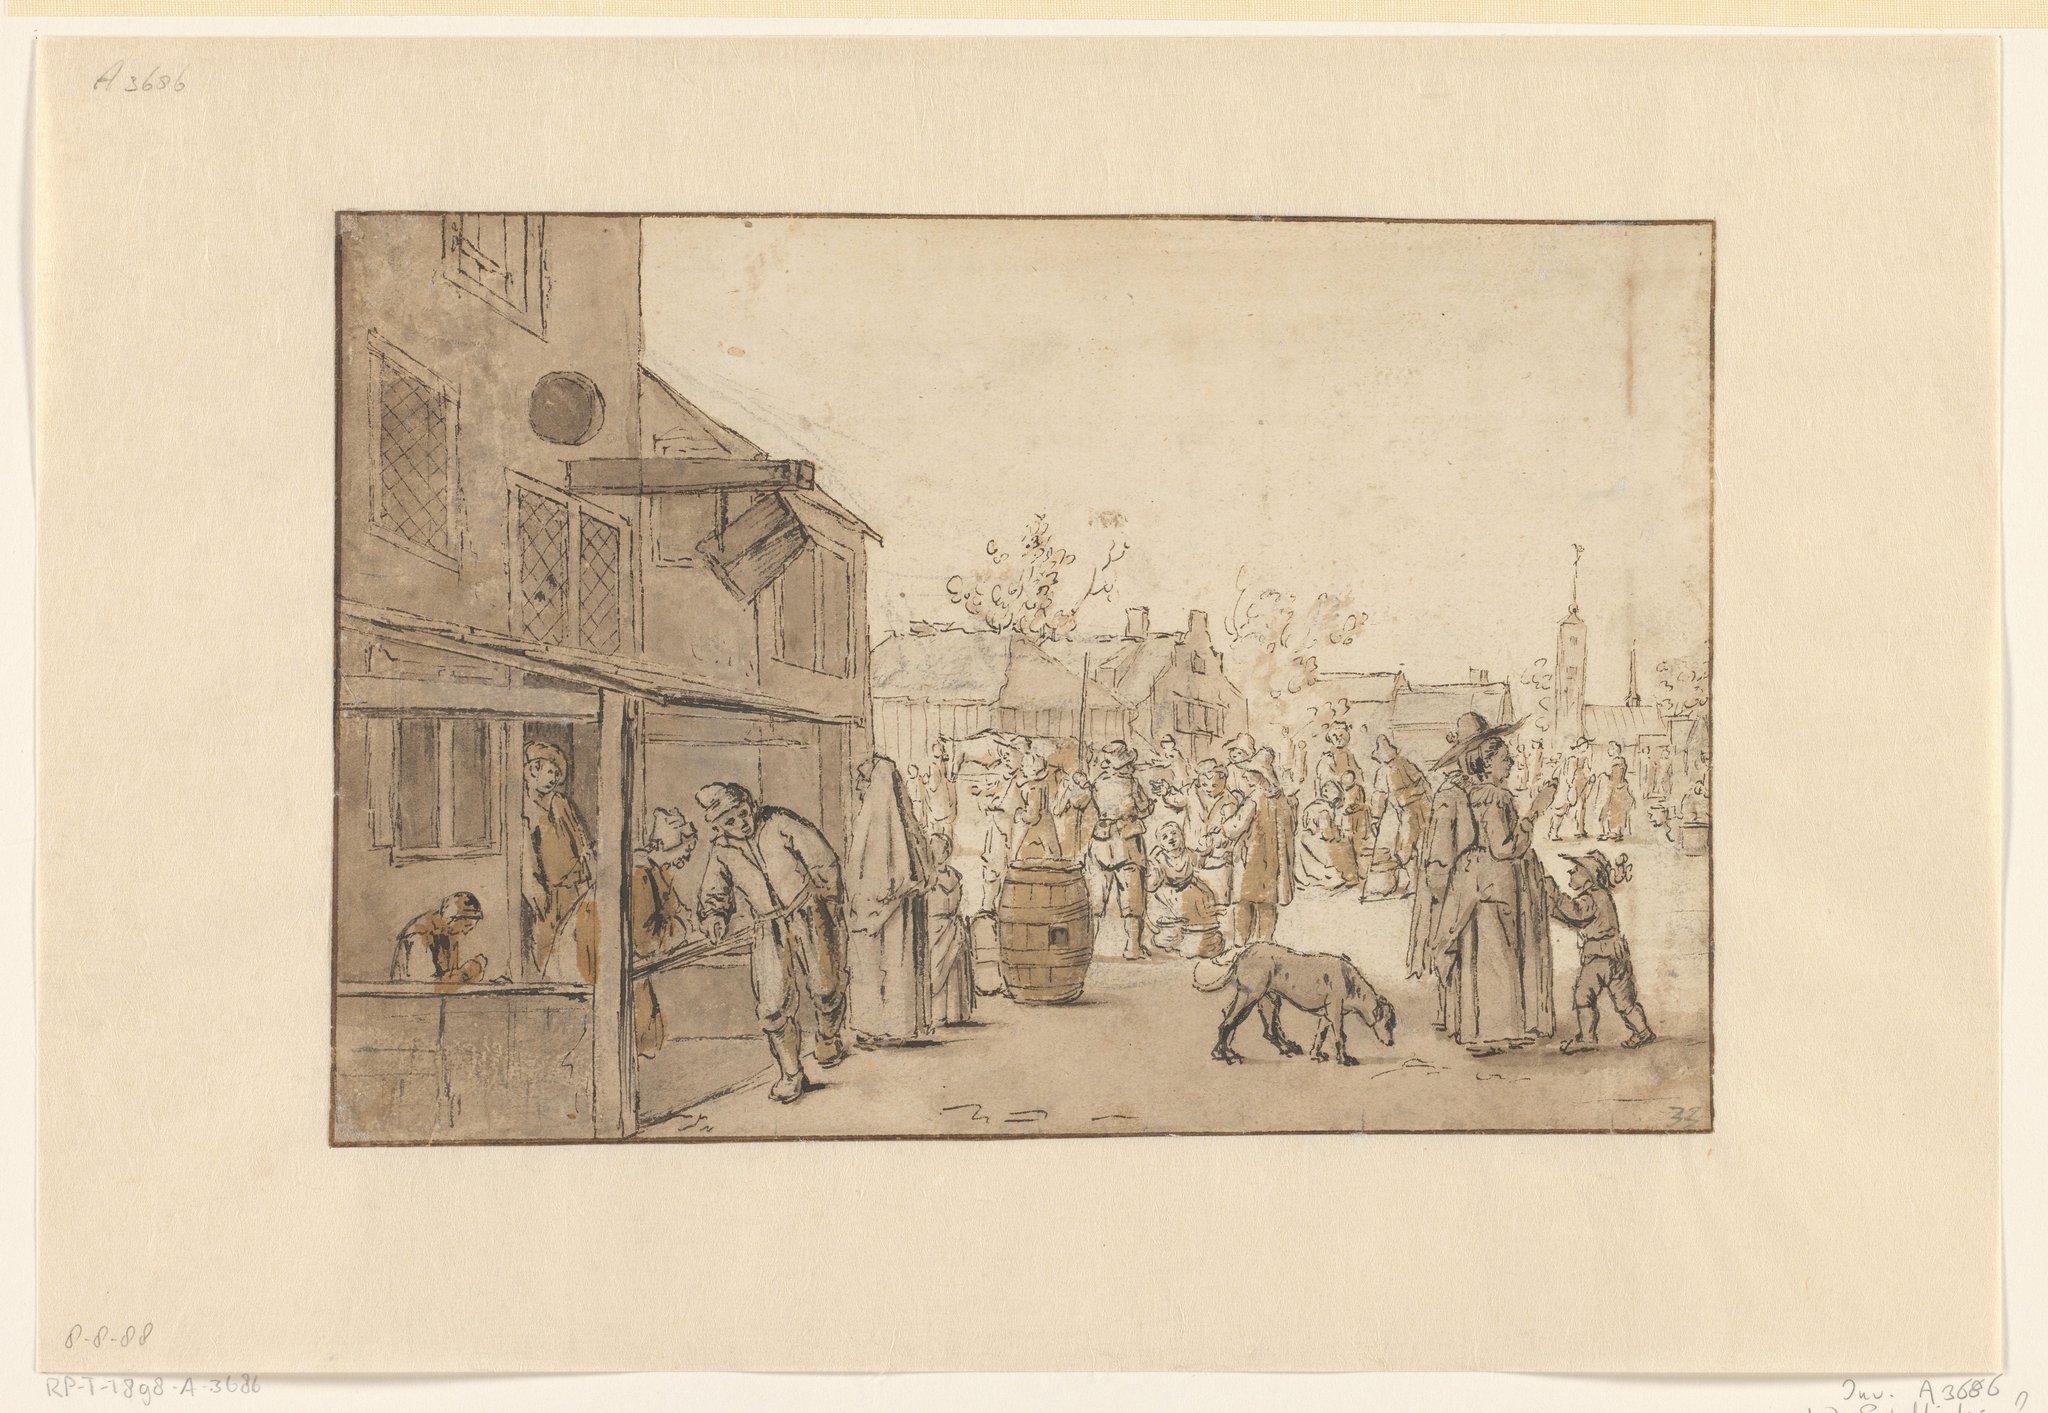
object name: drawing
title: Marktscène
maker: willem schellinks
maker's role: draughtsman, painter, print maker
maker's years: 1627-1678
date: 1637-1678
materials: chalk, ink, paper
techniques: brush, pen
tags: market